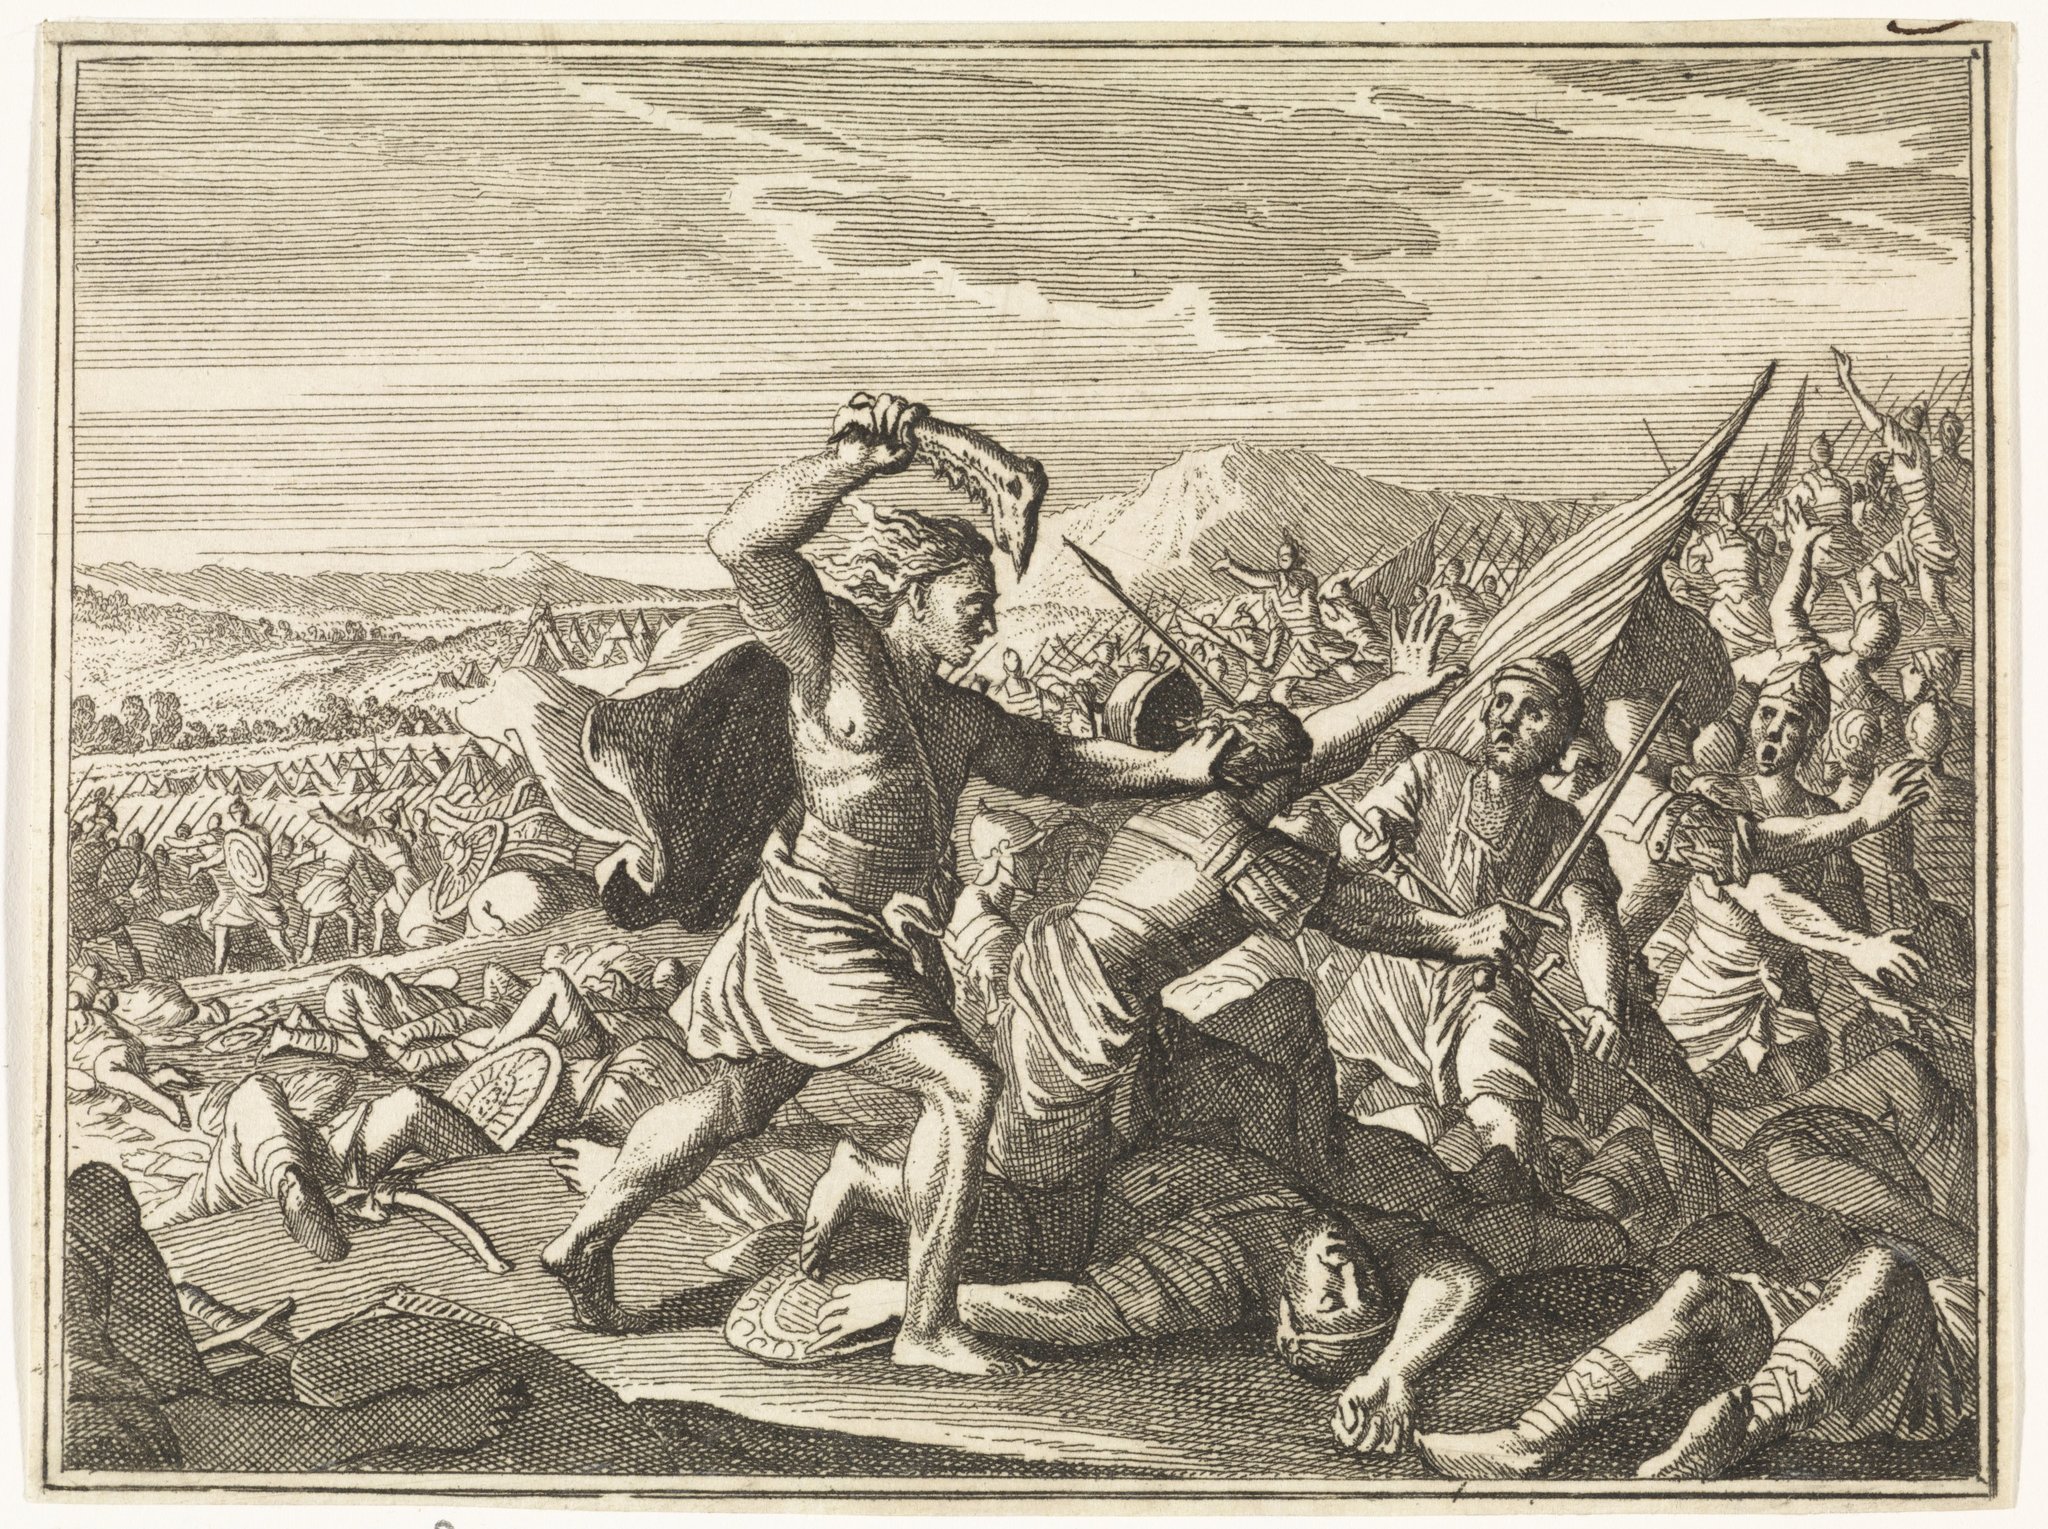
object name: print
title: Simson verslaat de Filistijnen met een ezelskaak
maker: caspar luyken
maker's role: draughtsman, print maker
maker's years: 1672-1708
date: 1712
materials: paper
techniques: etching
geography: amsterdam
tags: with an ass's jaw-bone samson slays a thousand philistines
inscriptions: collector's mark: Lugt 2228, number: ‘89’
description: Illustratie uit: Luyken, Jan. De schriftuurlyke geschiedenissen en gelykenissen van het Oude en Nieuwe Verbond, 2 delen. Amsterdam: Wed. Pieter Arentsz II en Cornelis van der Sys, 1712, dl. I.